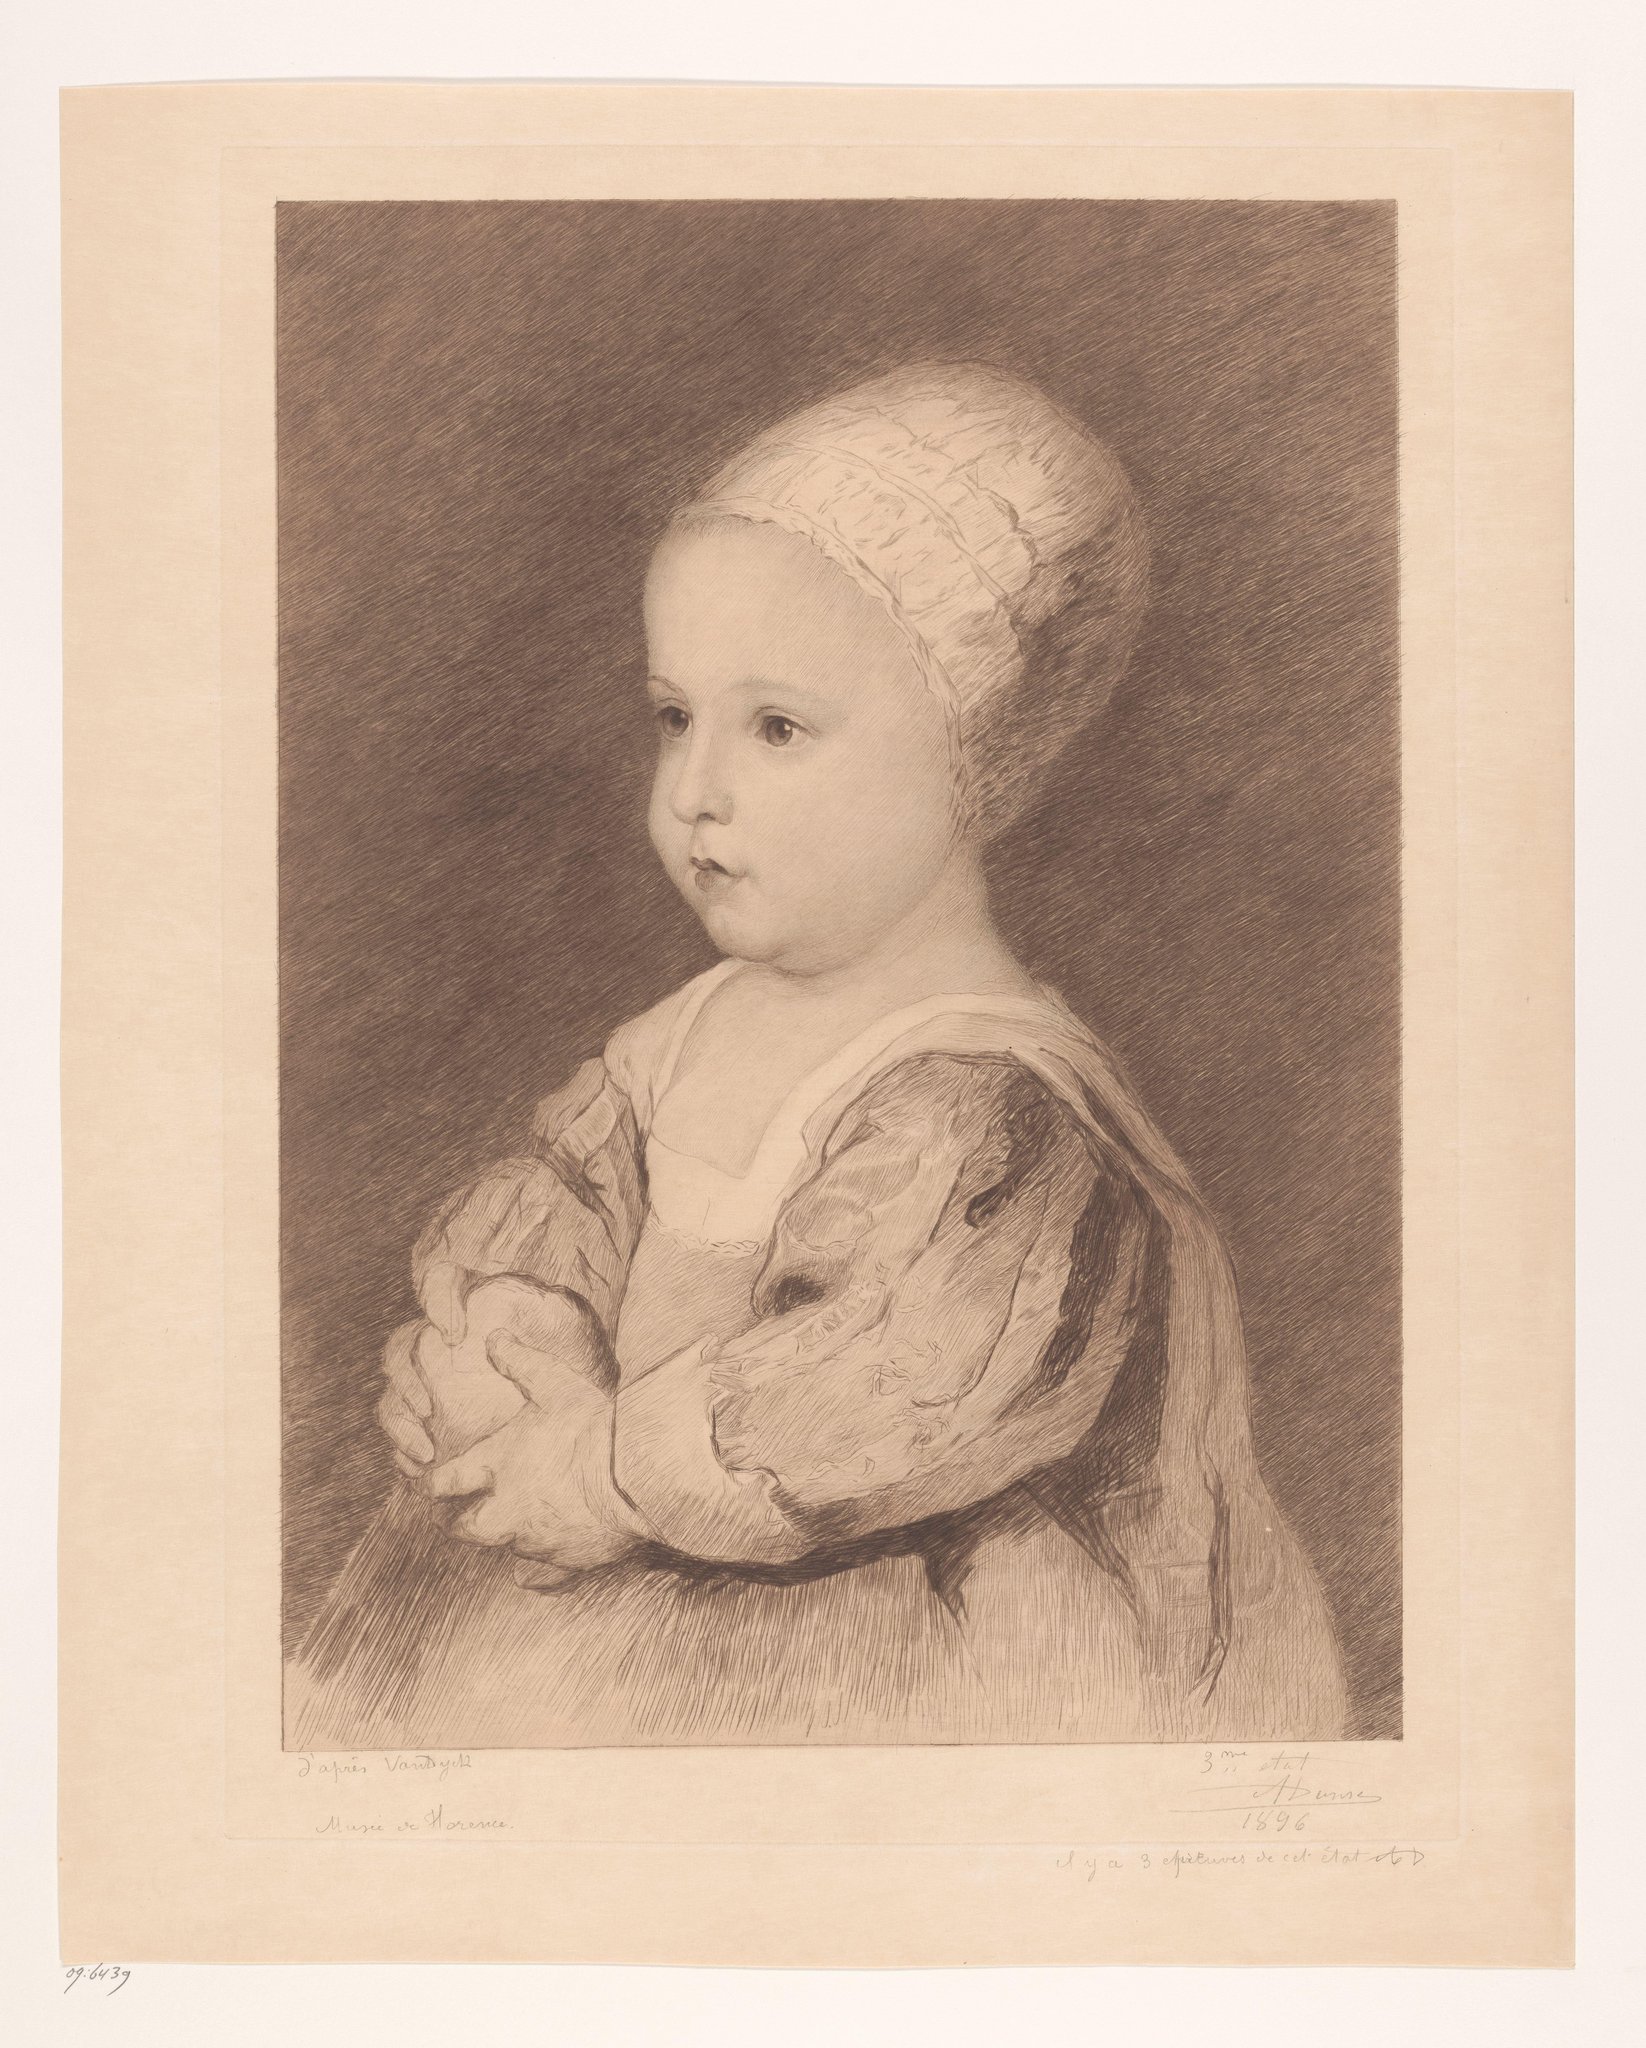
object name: print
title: Portret van een onbekend kind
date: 1896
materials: paper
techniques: drypoint, etching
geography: belgium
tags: child between toddler and youth (of undetermined sex)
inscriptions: collector's mark: Lugt 2228, annotation: ‘il y a 3 épreuves de cet état’